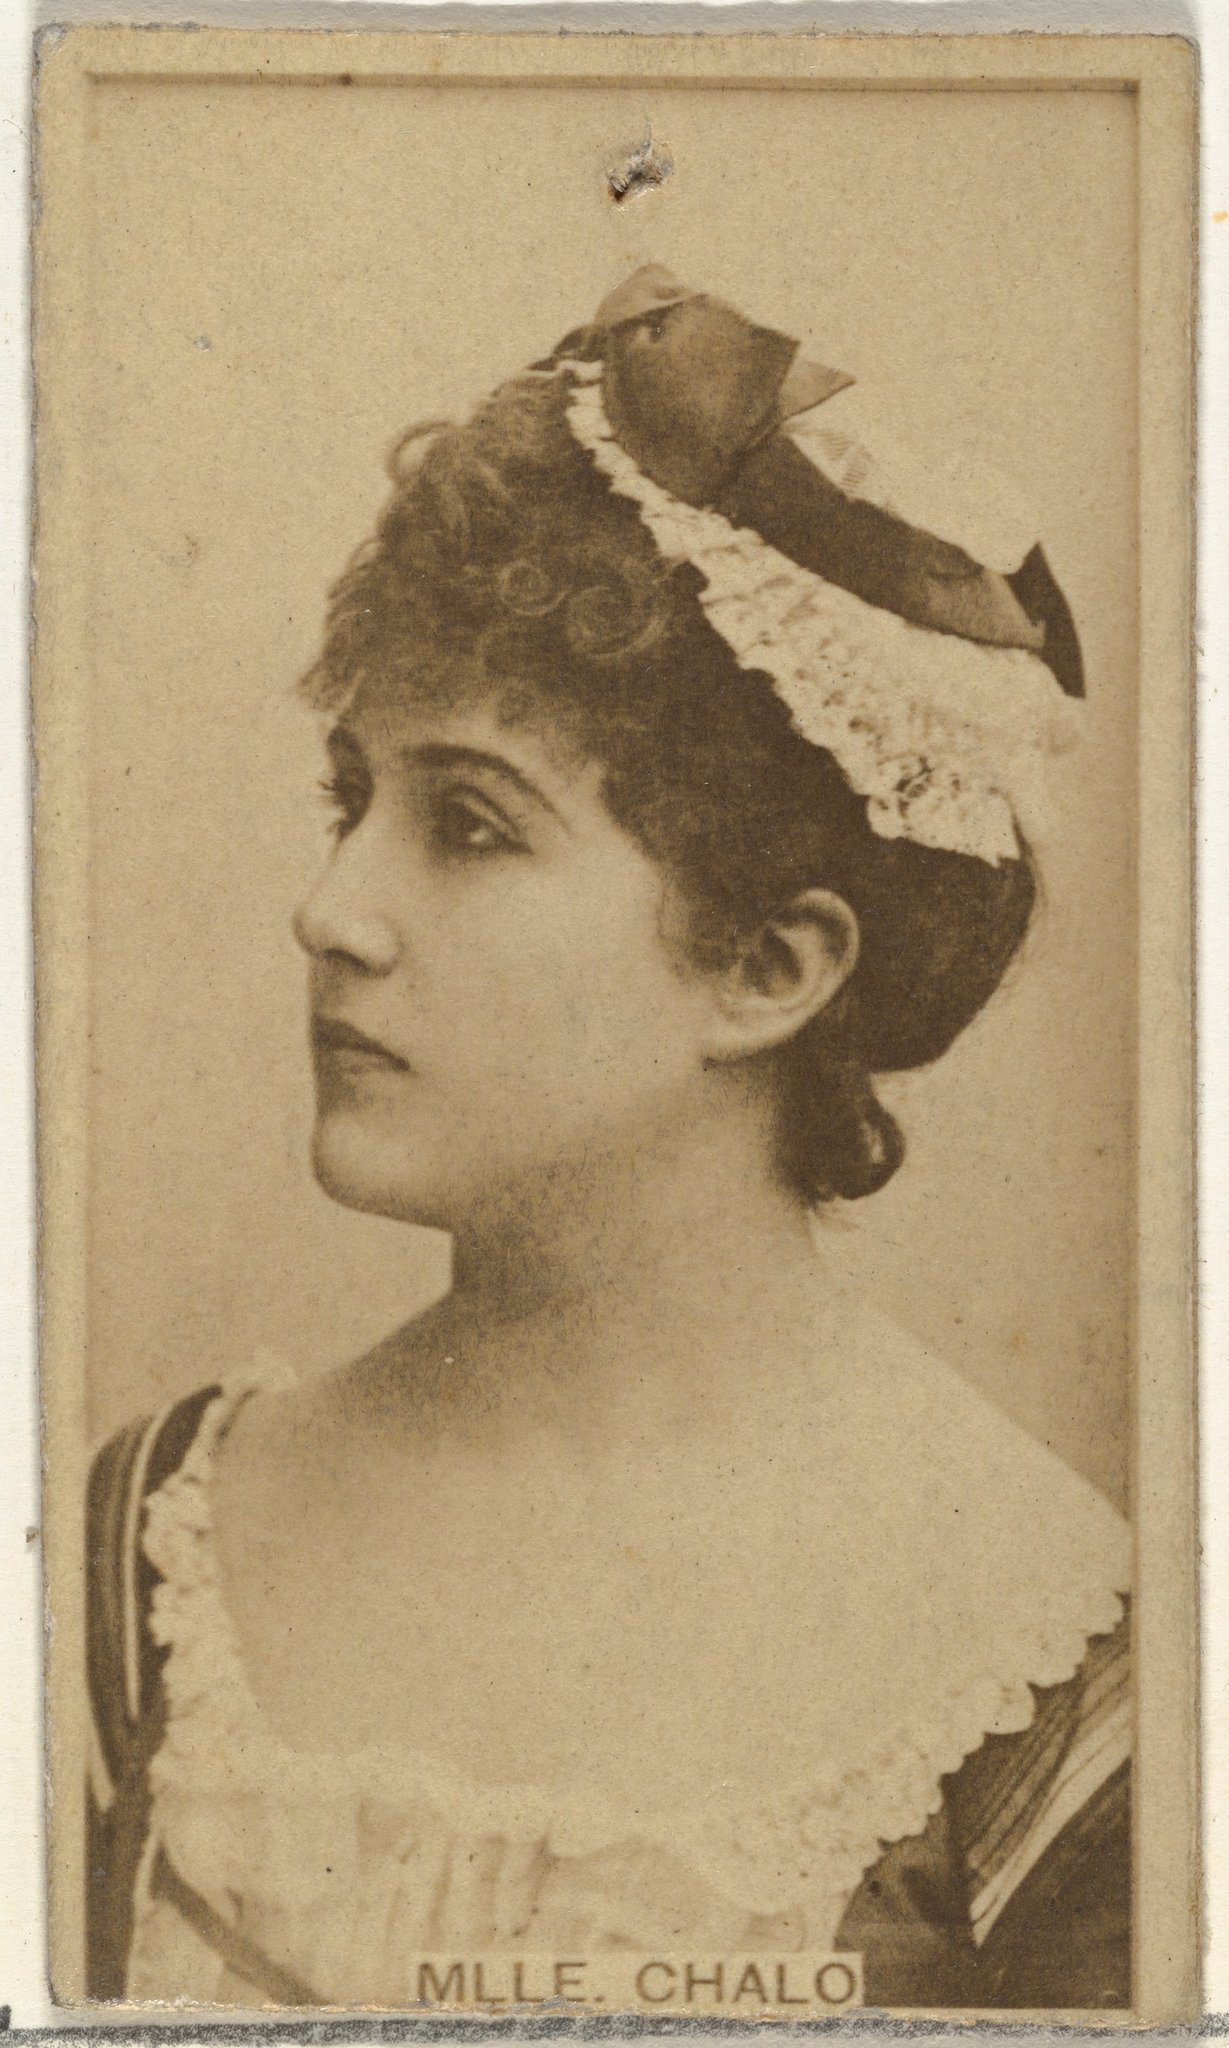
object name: photograph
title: Mlle. Chalo, from the Actors and Actresses series (N145-8) issued by Duke Sons & Co. to promote Duke Cigarettes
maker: w. duke, sons & co.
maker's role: publisher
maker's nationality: american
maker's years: 1870-1920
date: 1891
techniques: albumen silver print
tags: portraits,women,actresses